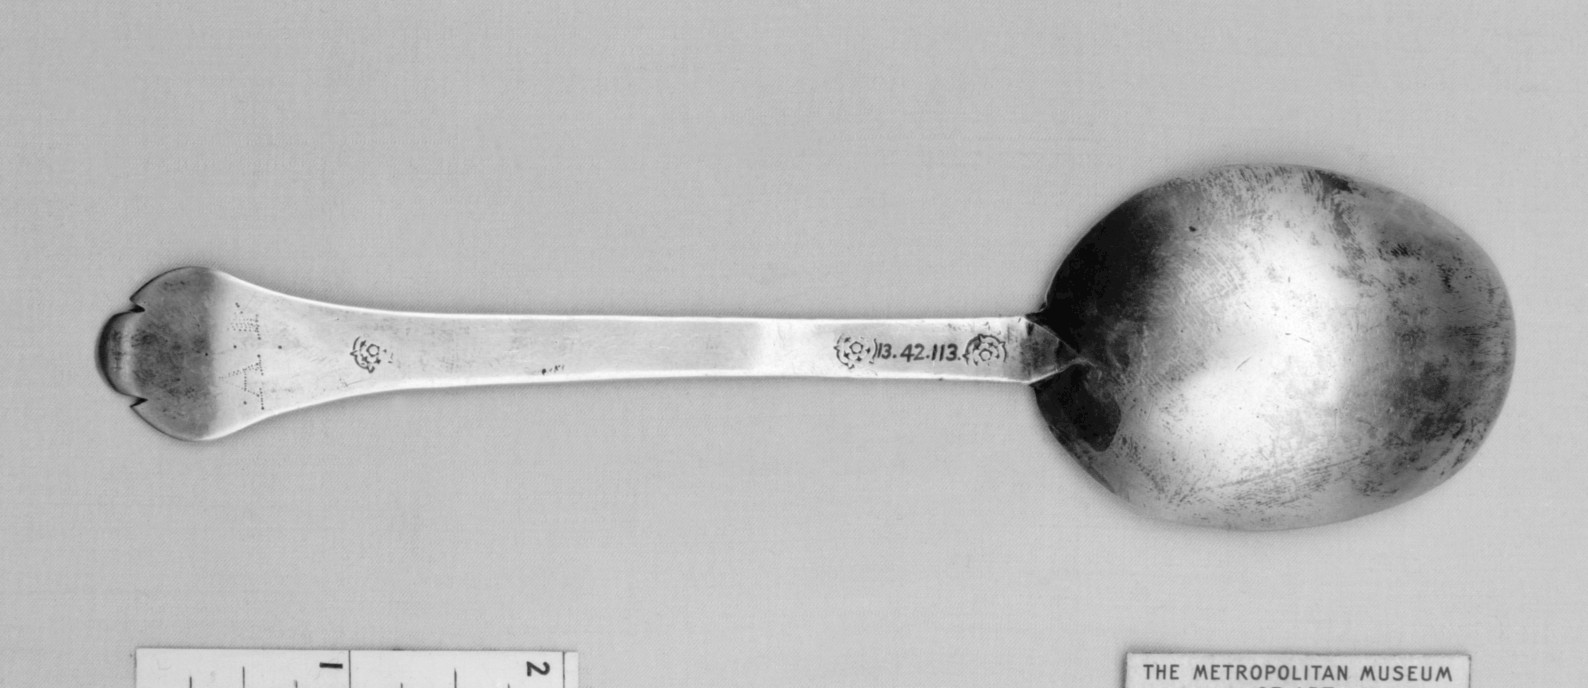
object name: spoon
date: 1650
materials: silver